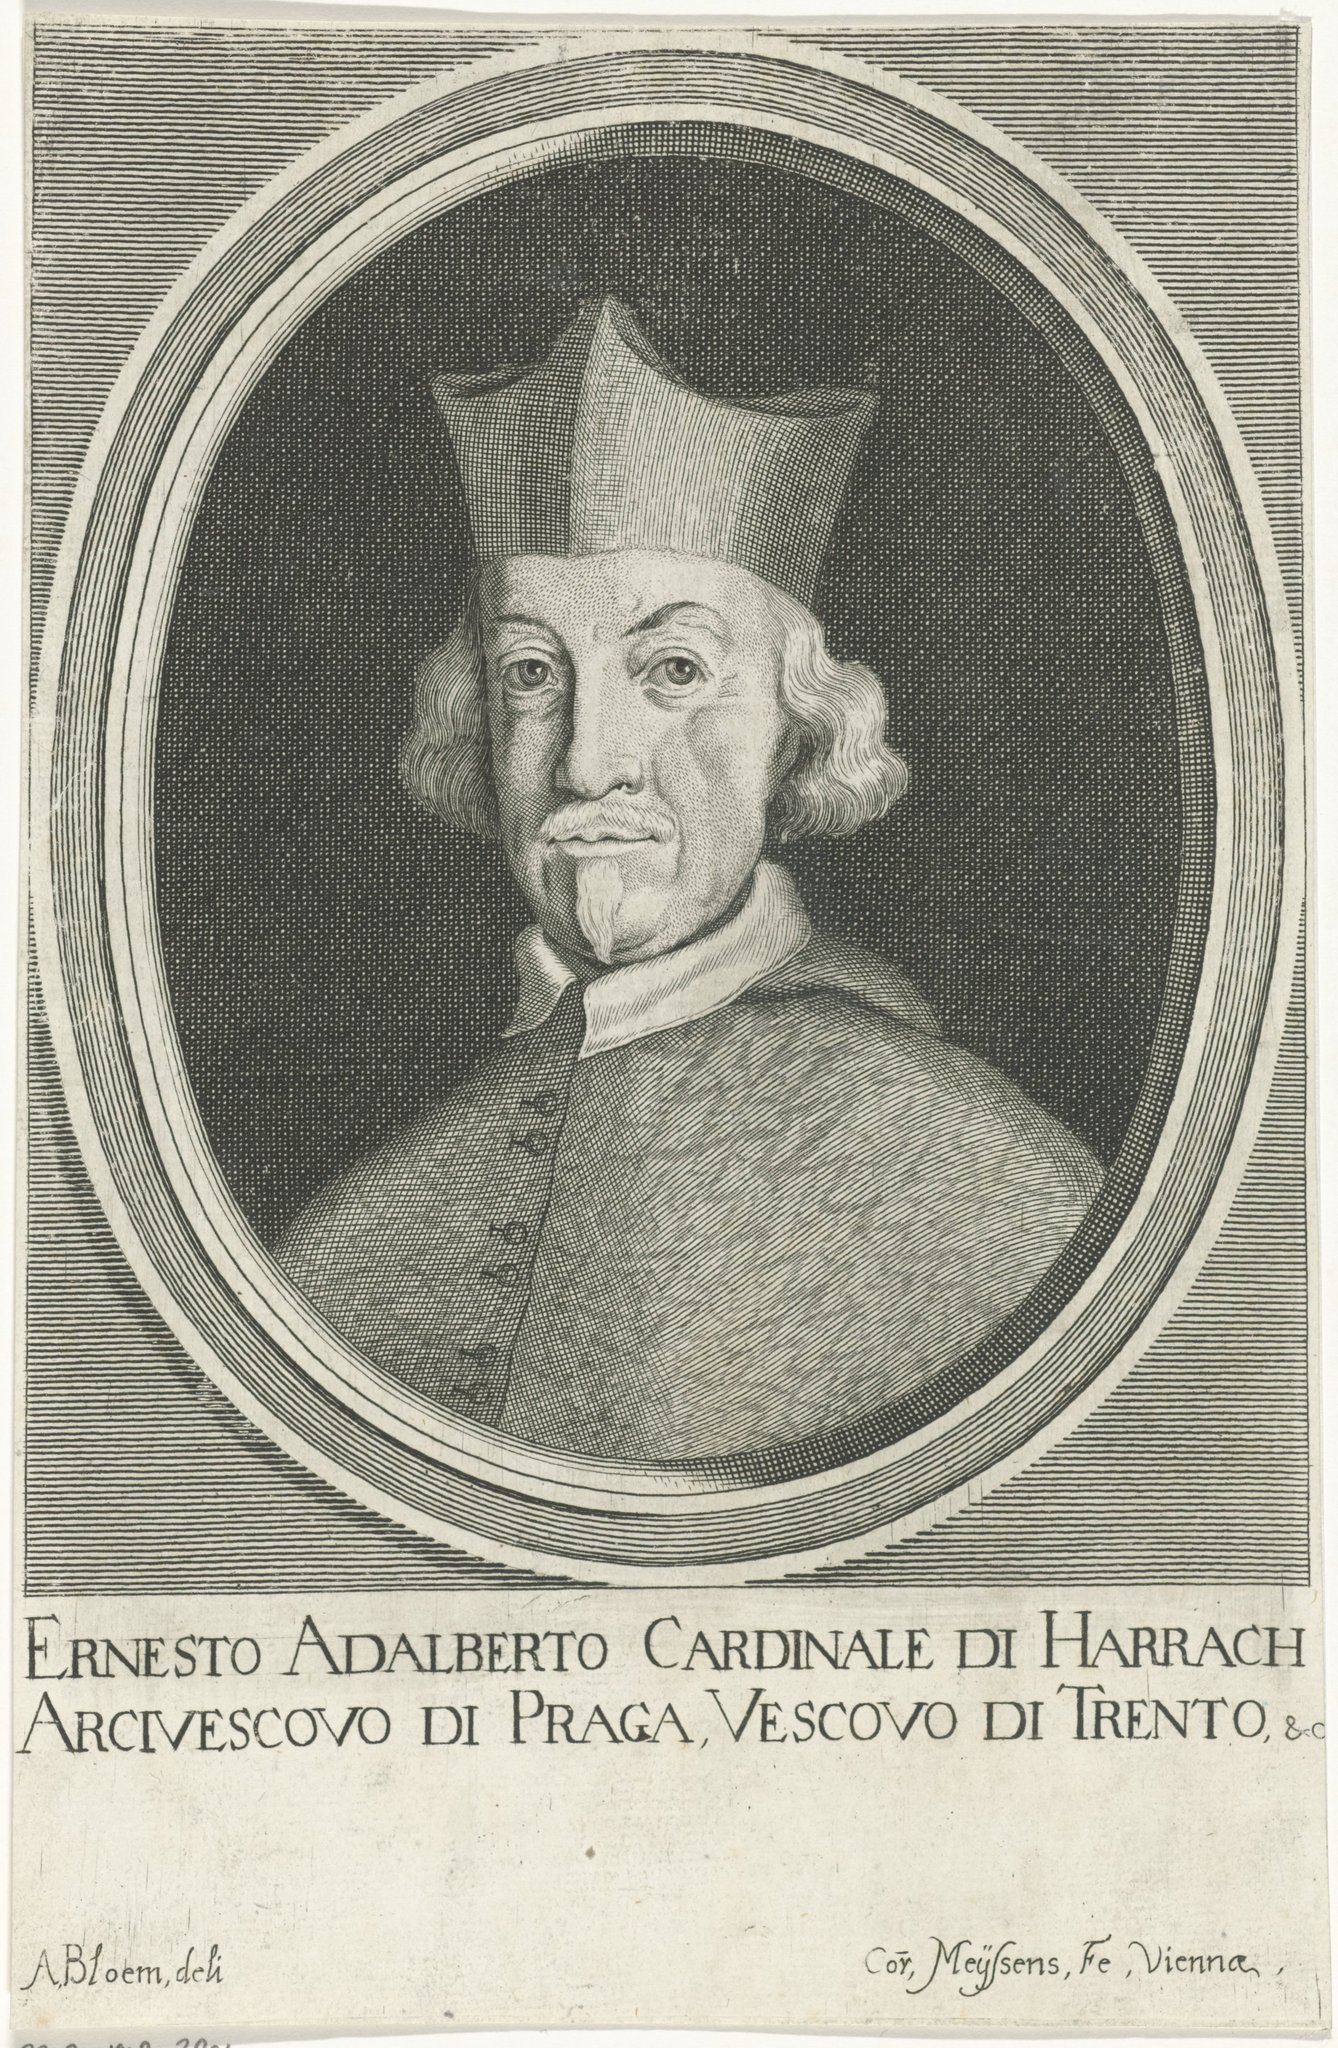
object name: print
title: Portret van Ernst Adalbert von Harrach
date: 1670-1674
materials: paper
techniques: engraving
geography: vienna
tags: vienna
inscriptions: collector's mark: Lugt 2228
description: Portret van Ernst Adalbert von Harrach, aartsbisschop van Praag en prins-bisschop van Trente. Onderaan in de marge zijn titel in het Italiaans.